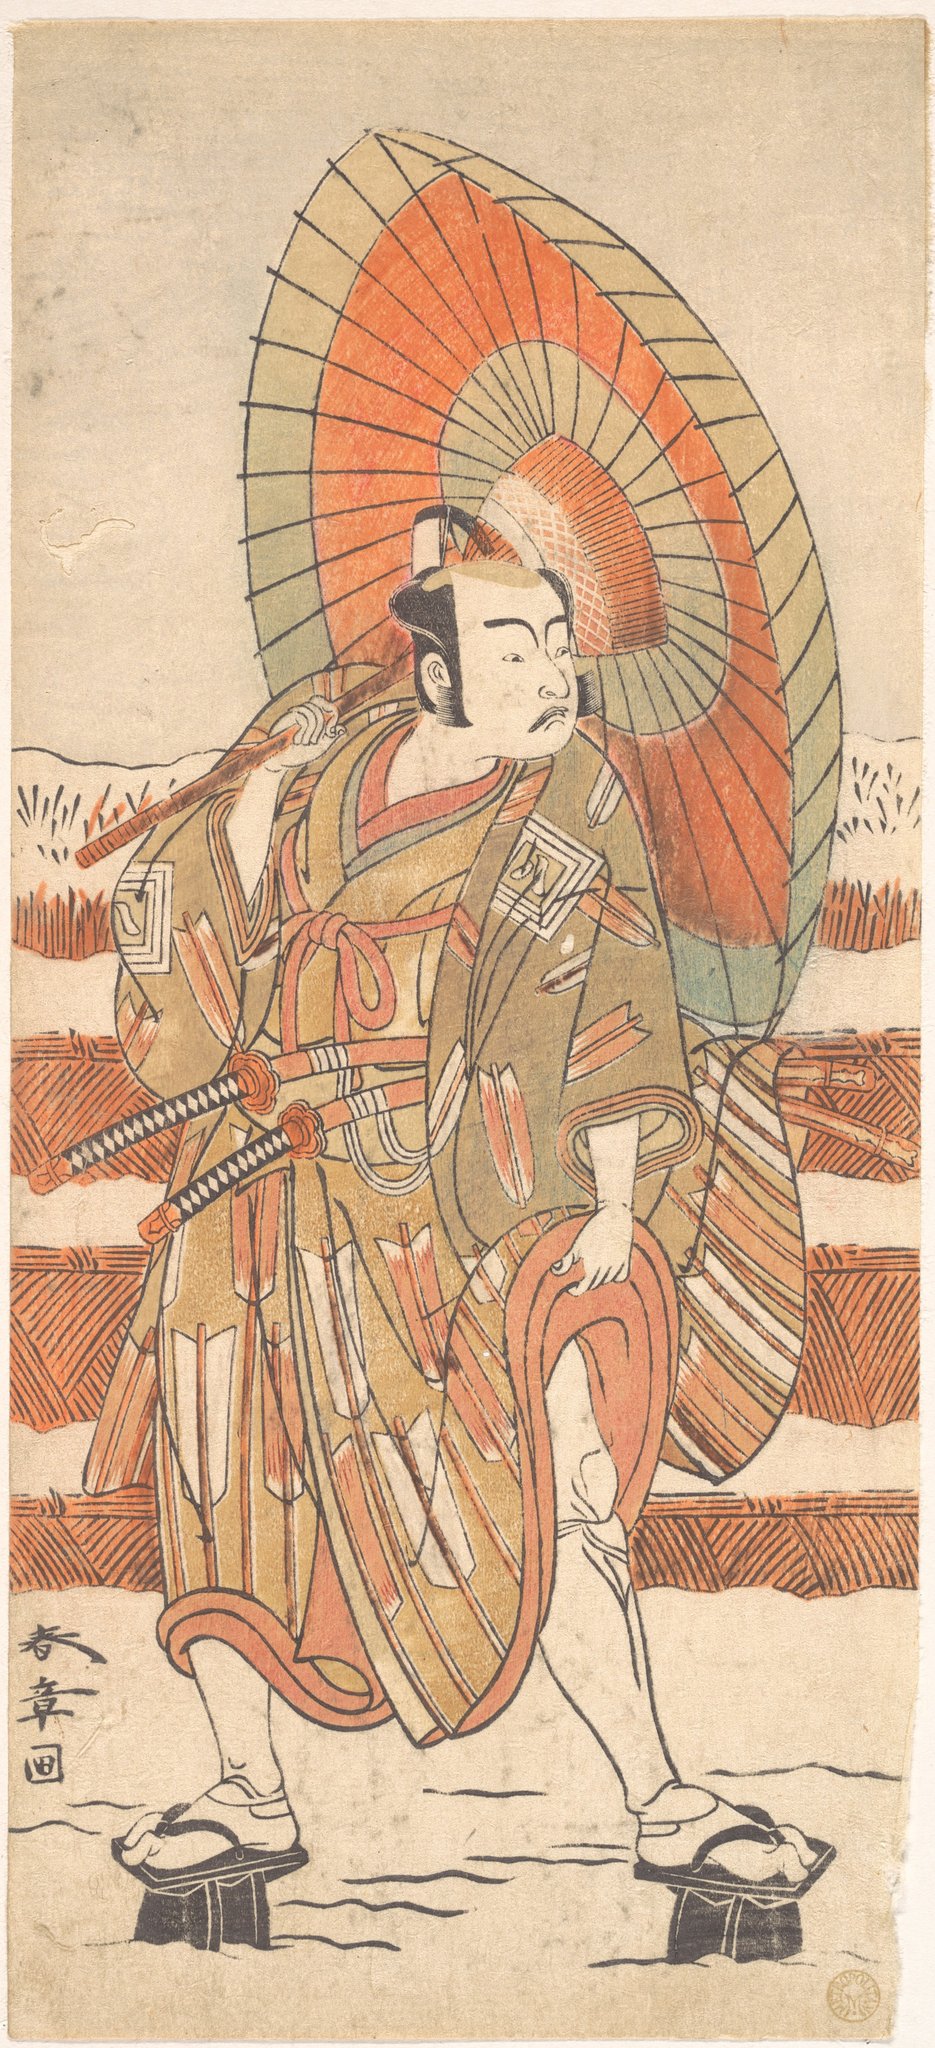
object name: woodblock print nishiki e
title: The Second Ichikawa Yaozo as a Samurai Standing in the Snow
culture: japanese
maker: katsukawa shunshō 勝川春章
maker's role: artist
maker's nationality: japanese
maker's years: 1726-1792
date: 1774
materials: ink, paper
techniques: nishiki e, woodblock print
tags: men,actors,umbrellas